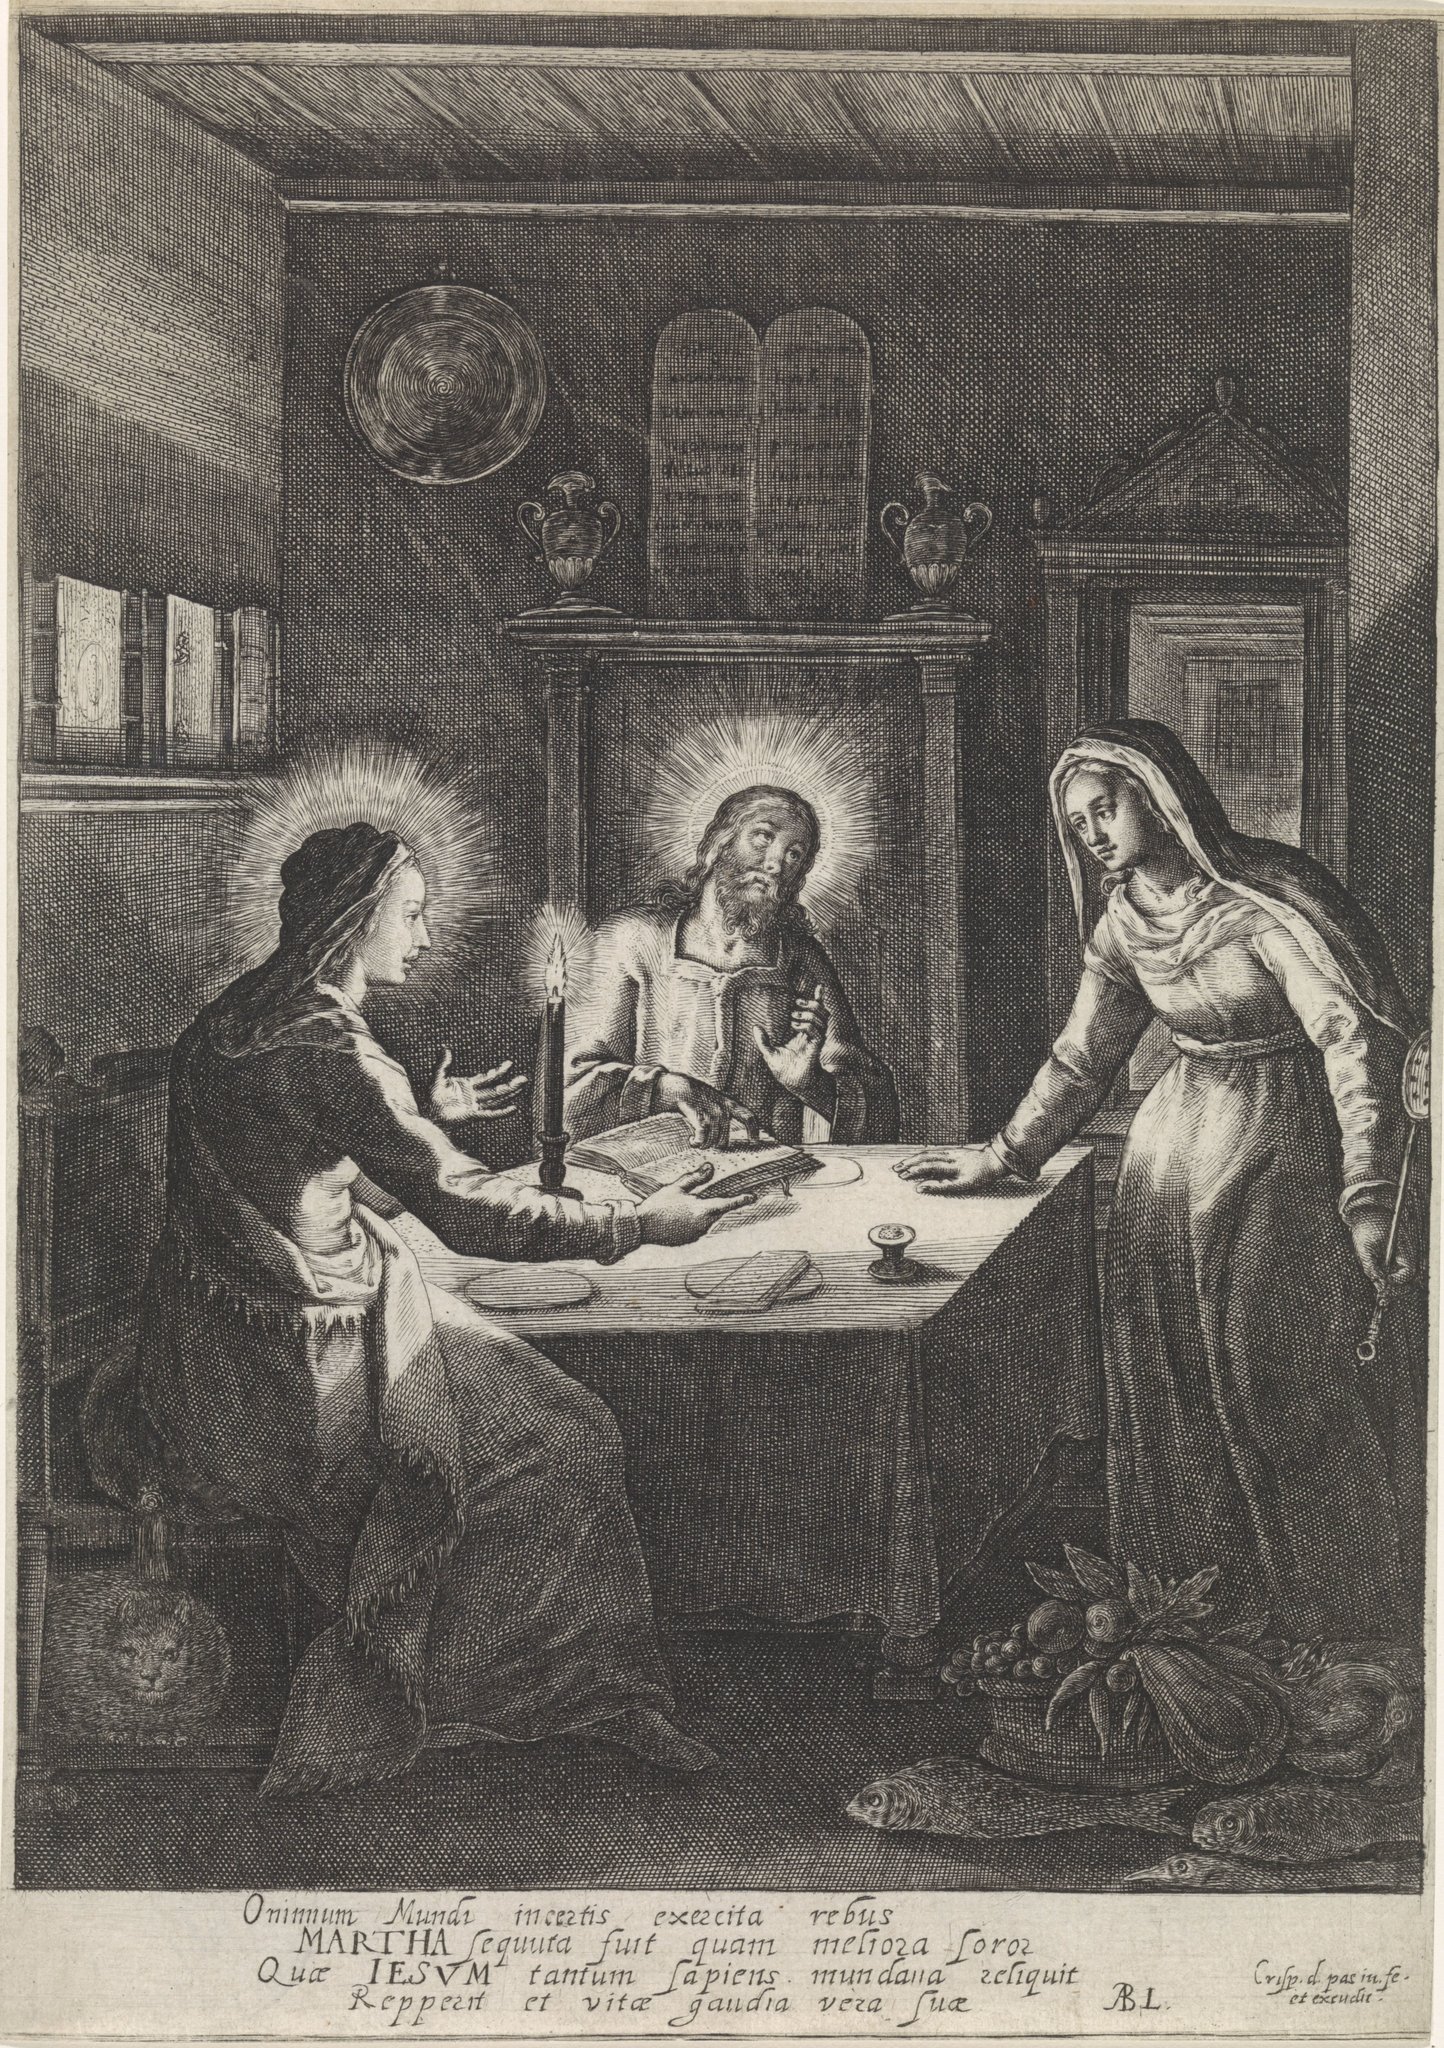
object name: print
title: Christus in het huis van Marta en Maria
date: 1574-1637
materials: paper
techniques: engraving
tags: christ in the house of martha and mary (luke 10:38-42)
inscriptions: collector's mark: Lugt 2228, collector's mark: Lugt 2760, collector's mark: Lugt 1209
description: Christus is te gast in het huis van de zussen Marta en Maria. Maria zit aan tafel met Christus en luistert aandachtig naar hem. Bij hen staat de vlijtige Marta met een schuimspaan in de hand, die haar zuster Maria berispt. In de marge een vierregelig onderschrift in het Latijn.